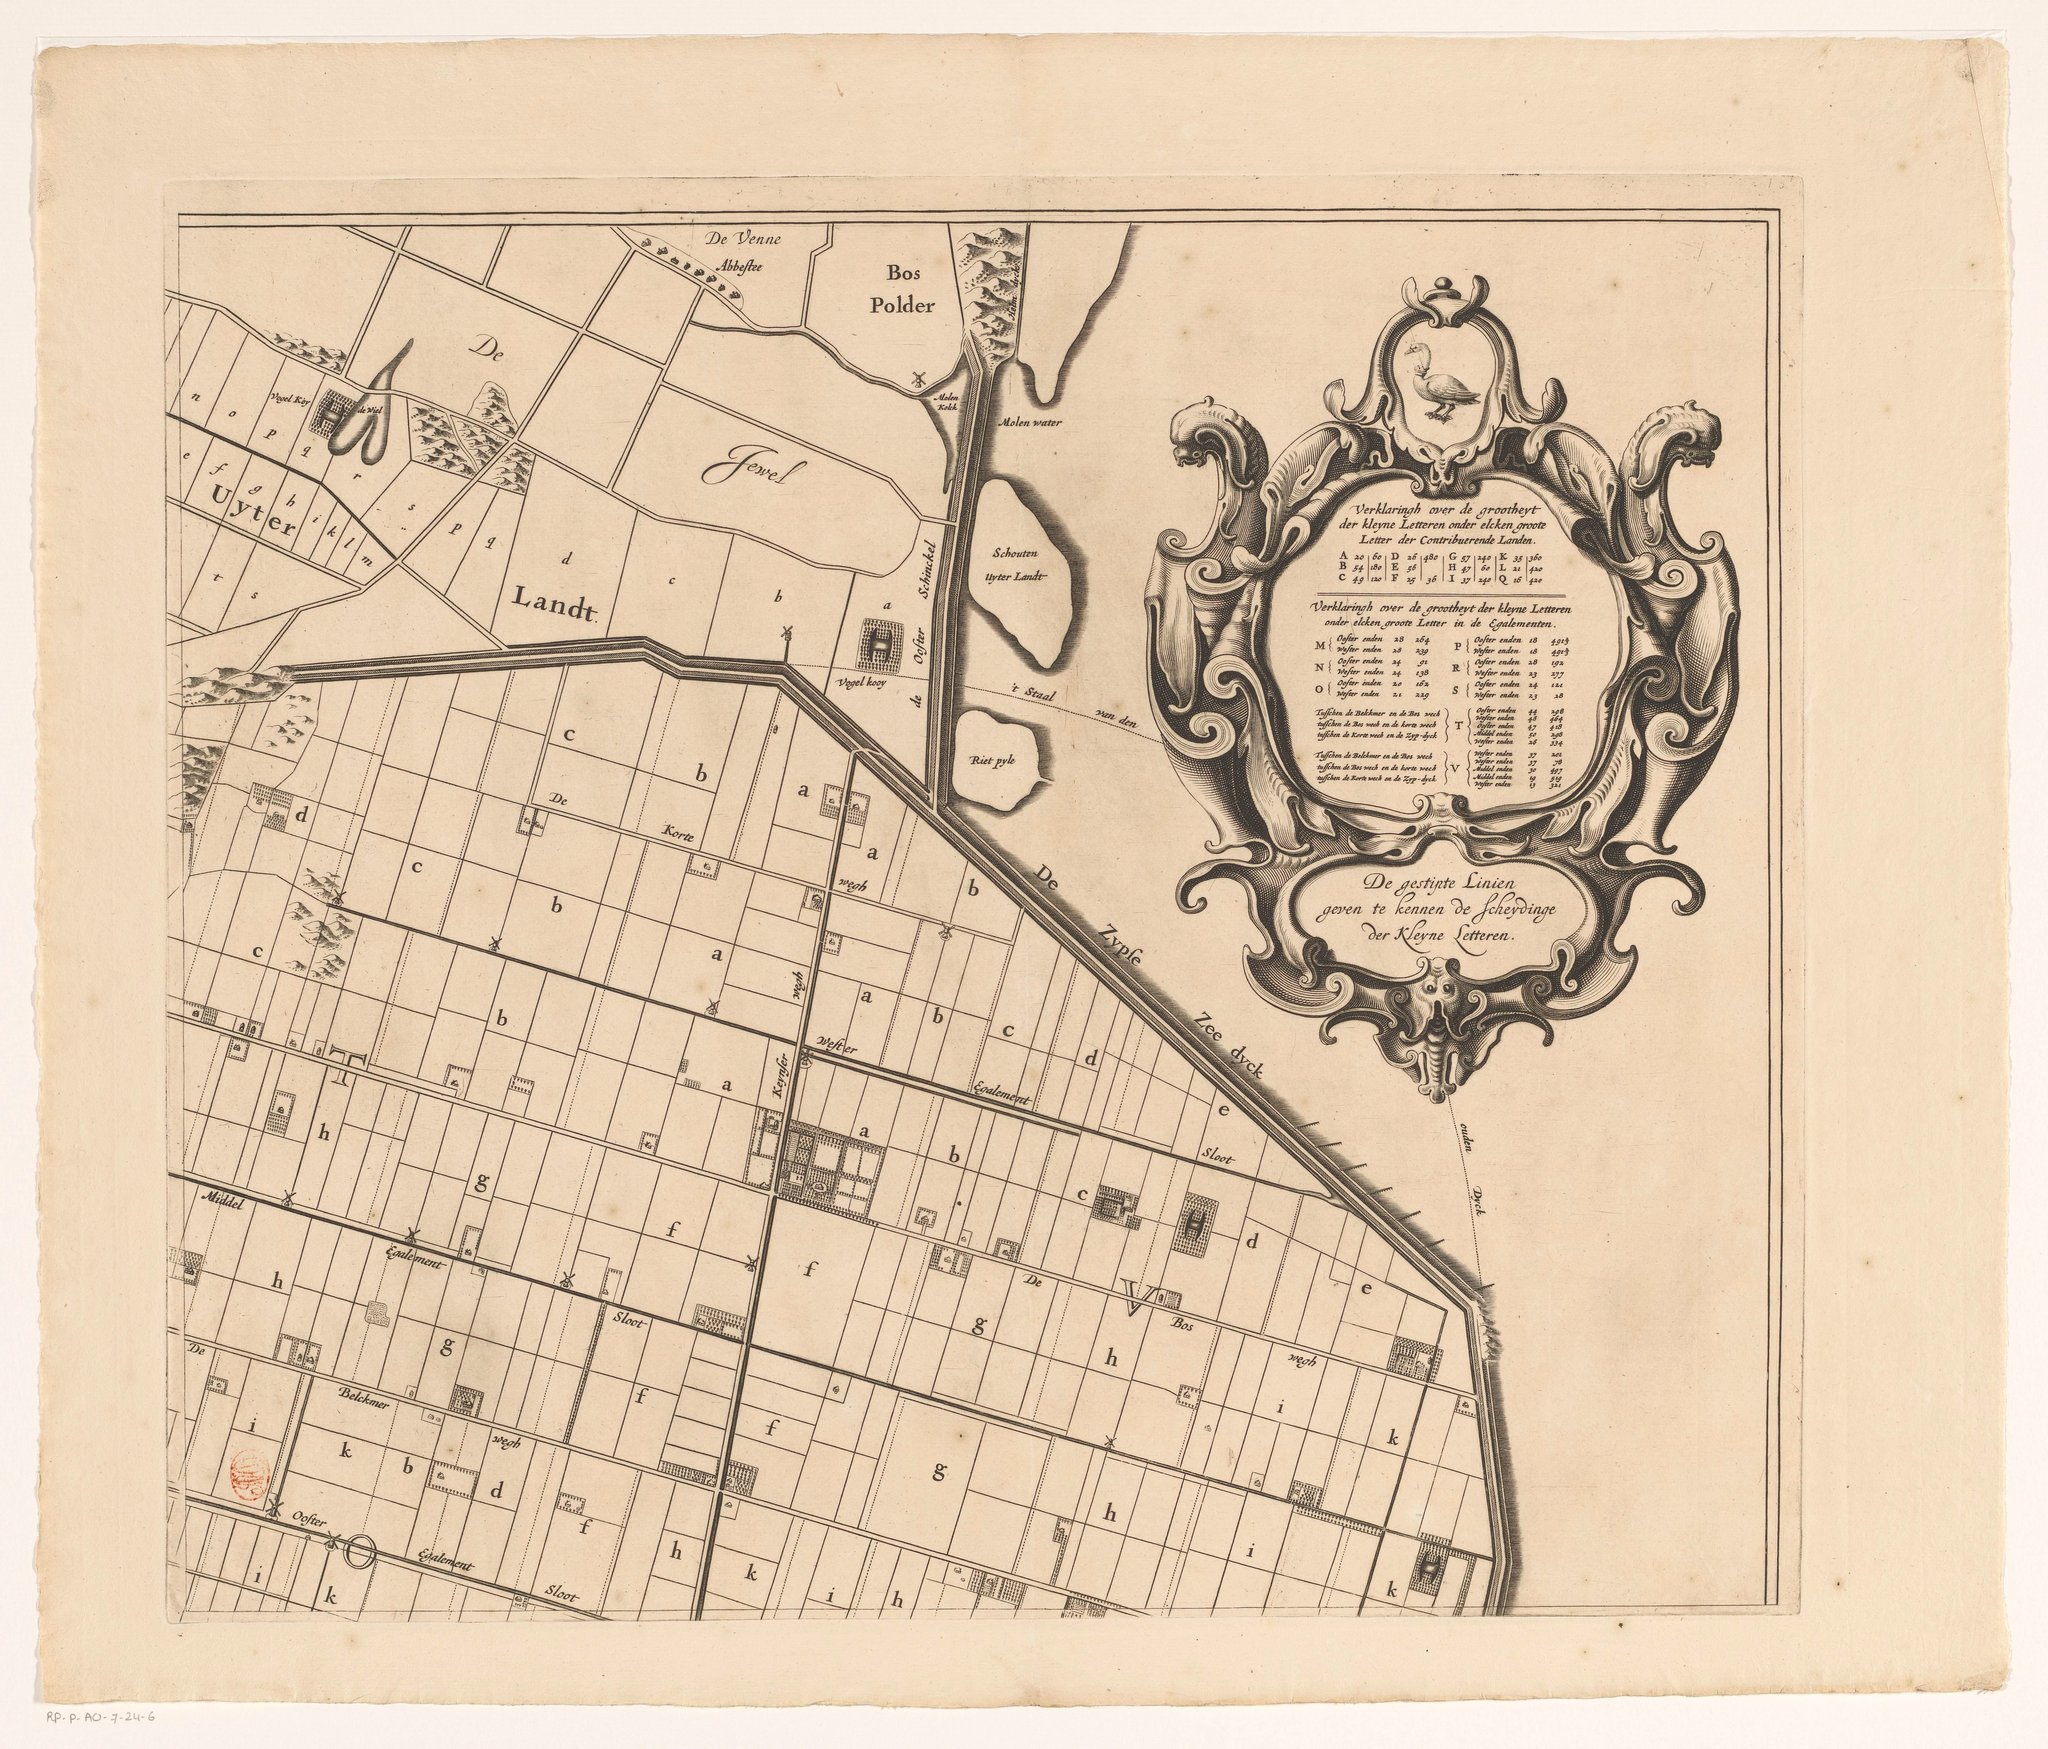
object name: map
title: Afbeelding van de Zyp. Haer waere gelegentheit van dyckage, weegen, watringen en schey-slooten; alle de hofsteden, wooningen en watermolens inde selve geleegen: mitsgaders rechte aenwysinge van de scheydinge haerder groote en kleyne letteren. Begrypende in haren omring de somme van 9060 morgens, yder tot 600 Roeden Hontsbosscher maet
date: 1665-1760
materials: paper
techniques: engraving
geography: gouda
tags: coat of arms (as symbol of the state, etc.), maps of separate countries or regions, polder, reclaimed land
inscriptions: collector's mark: Lugt 195, collector's mark: Lugt 2228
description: Deel (rechtsboven) van een kaart van de Zijpepolder.